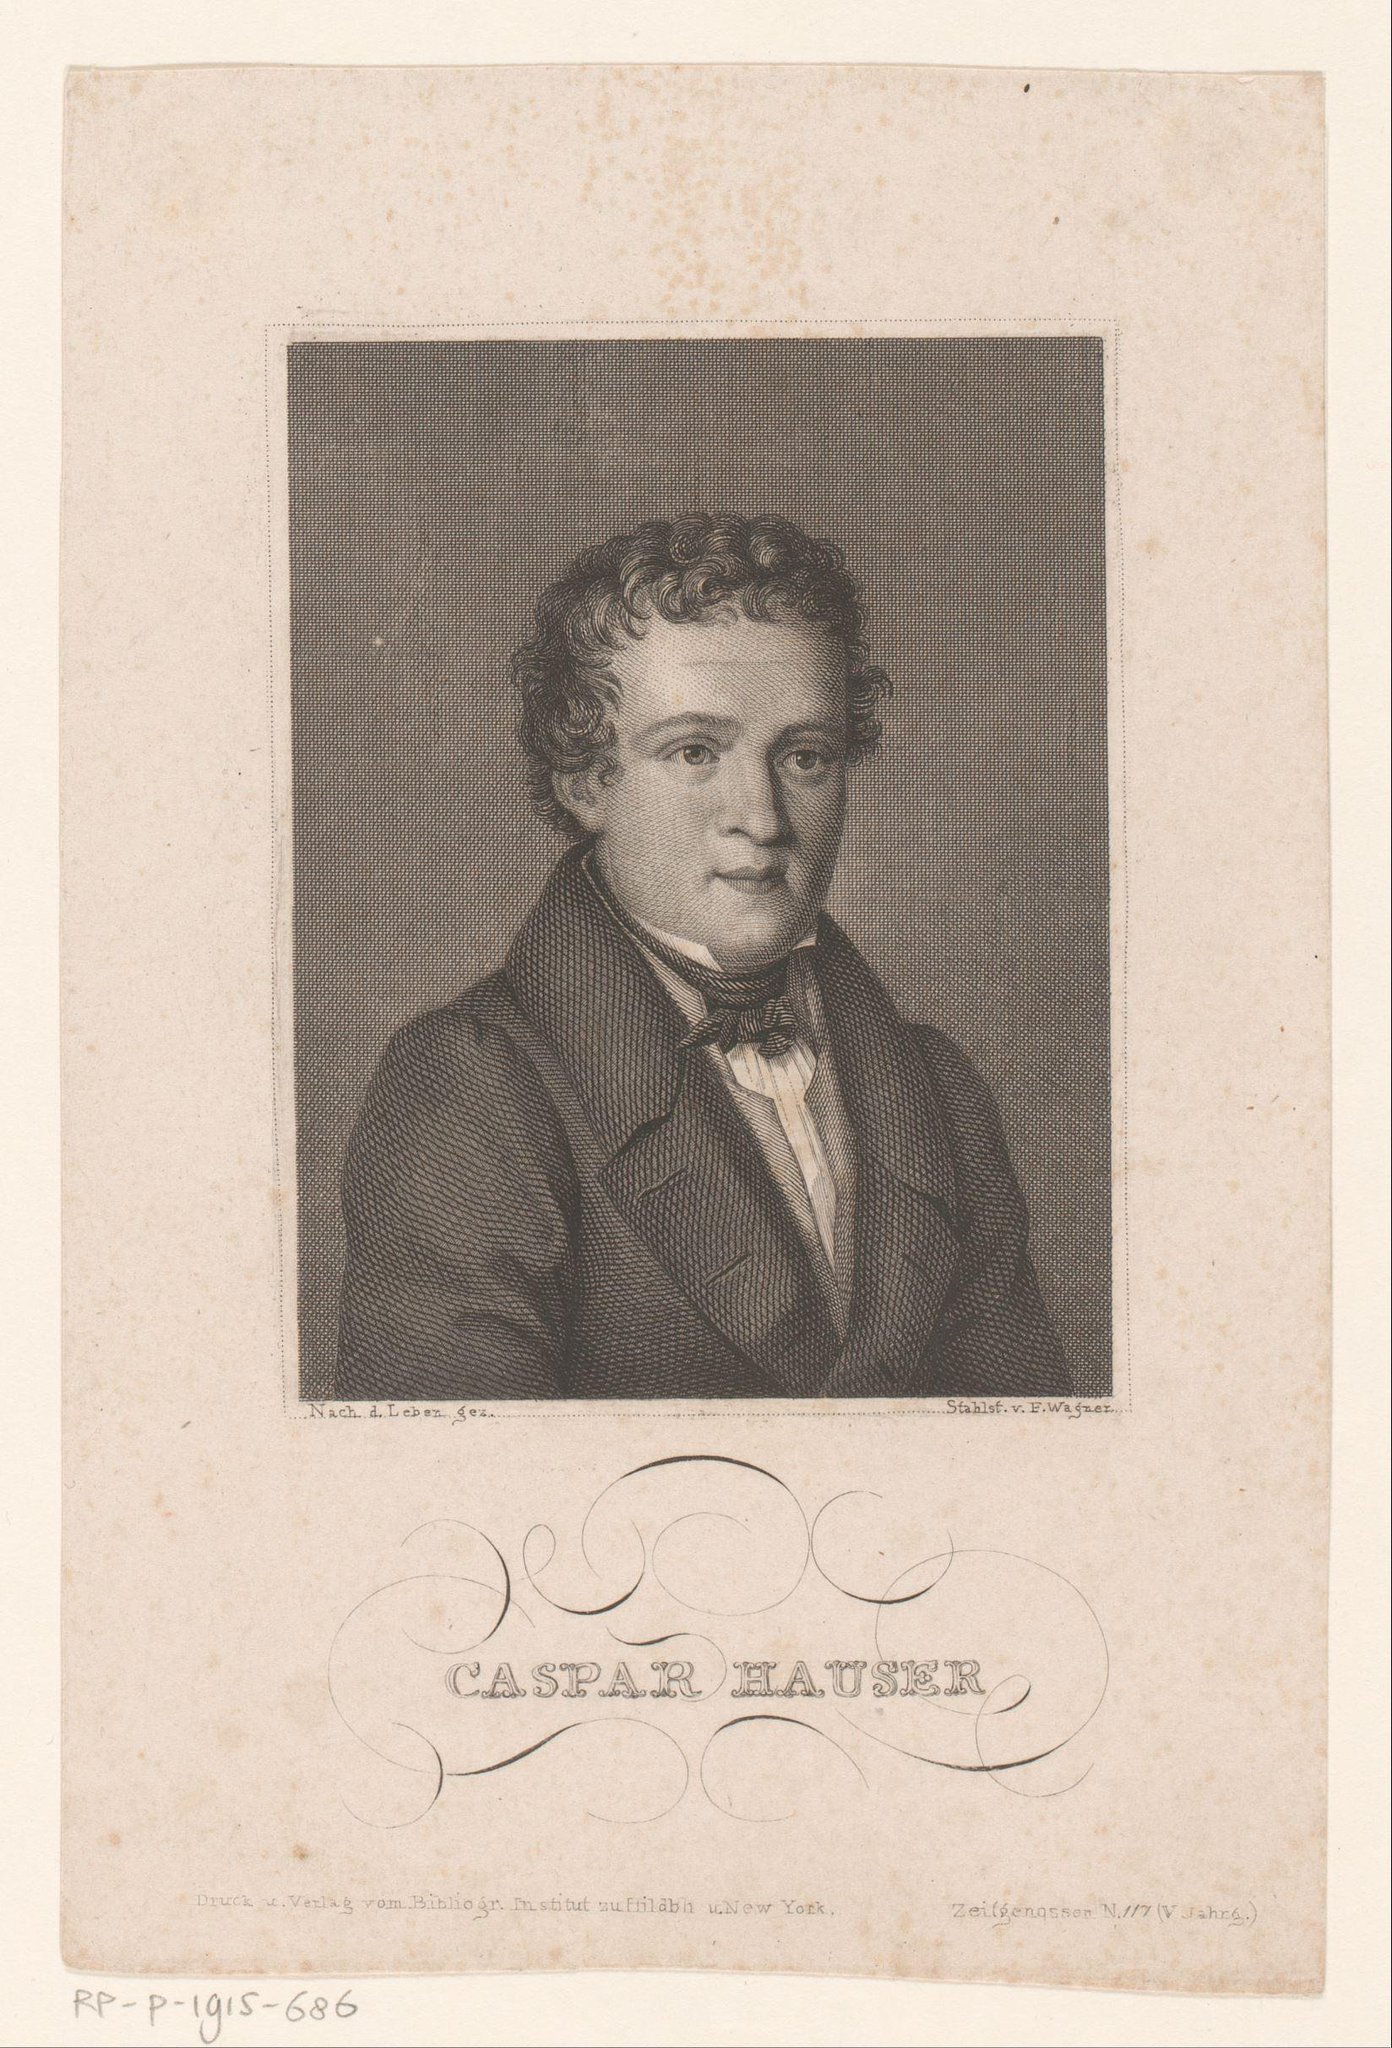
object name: print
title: Portret van Kaspar Hauser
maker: friedrich wagner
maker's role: painter, print maker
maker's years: 1801-1850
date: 1829-1840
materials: paper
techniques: engraving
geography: new york city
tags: historical persons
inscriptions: collector's mark: Lugt 2228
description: Rechtsonder: Zeitgenossen N. 117 (V Jahrg.).